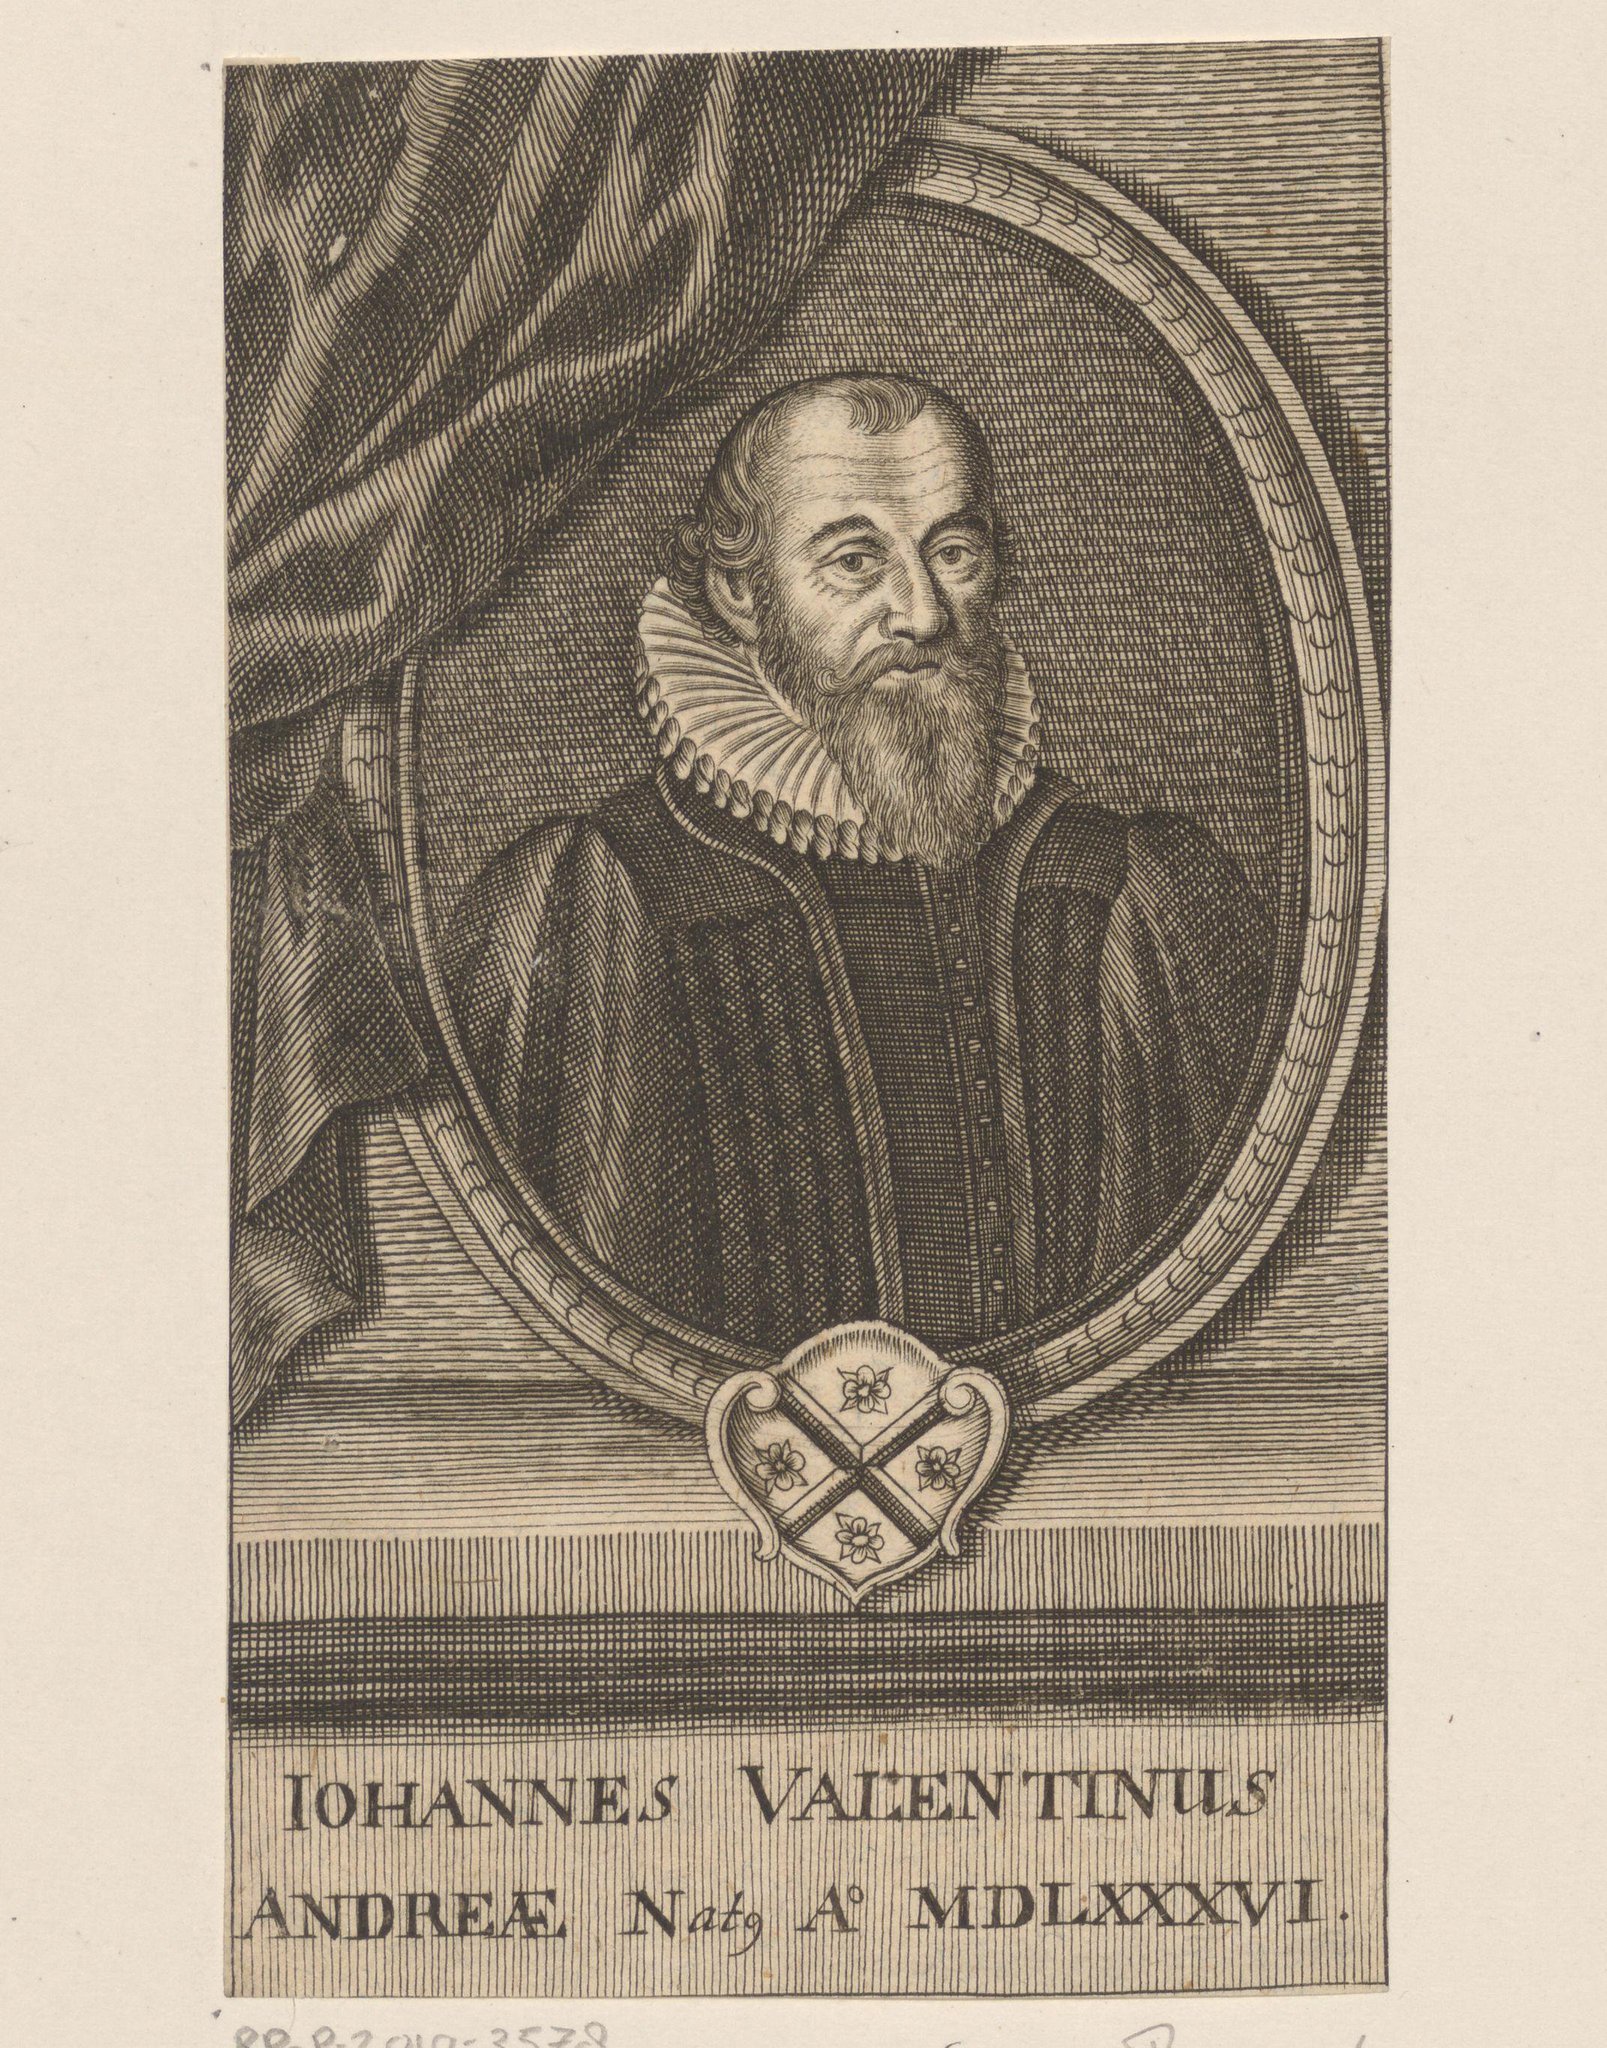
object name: print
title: Portret van Johann Valentin Andreae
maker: Anonymous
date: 1650-1749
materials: paper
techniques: engraving, etching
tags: theologian, historical persons, armorial bearing, heraldry